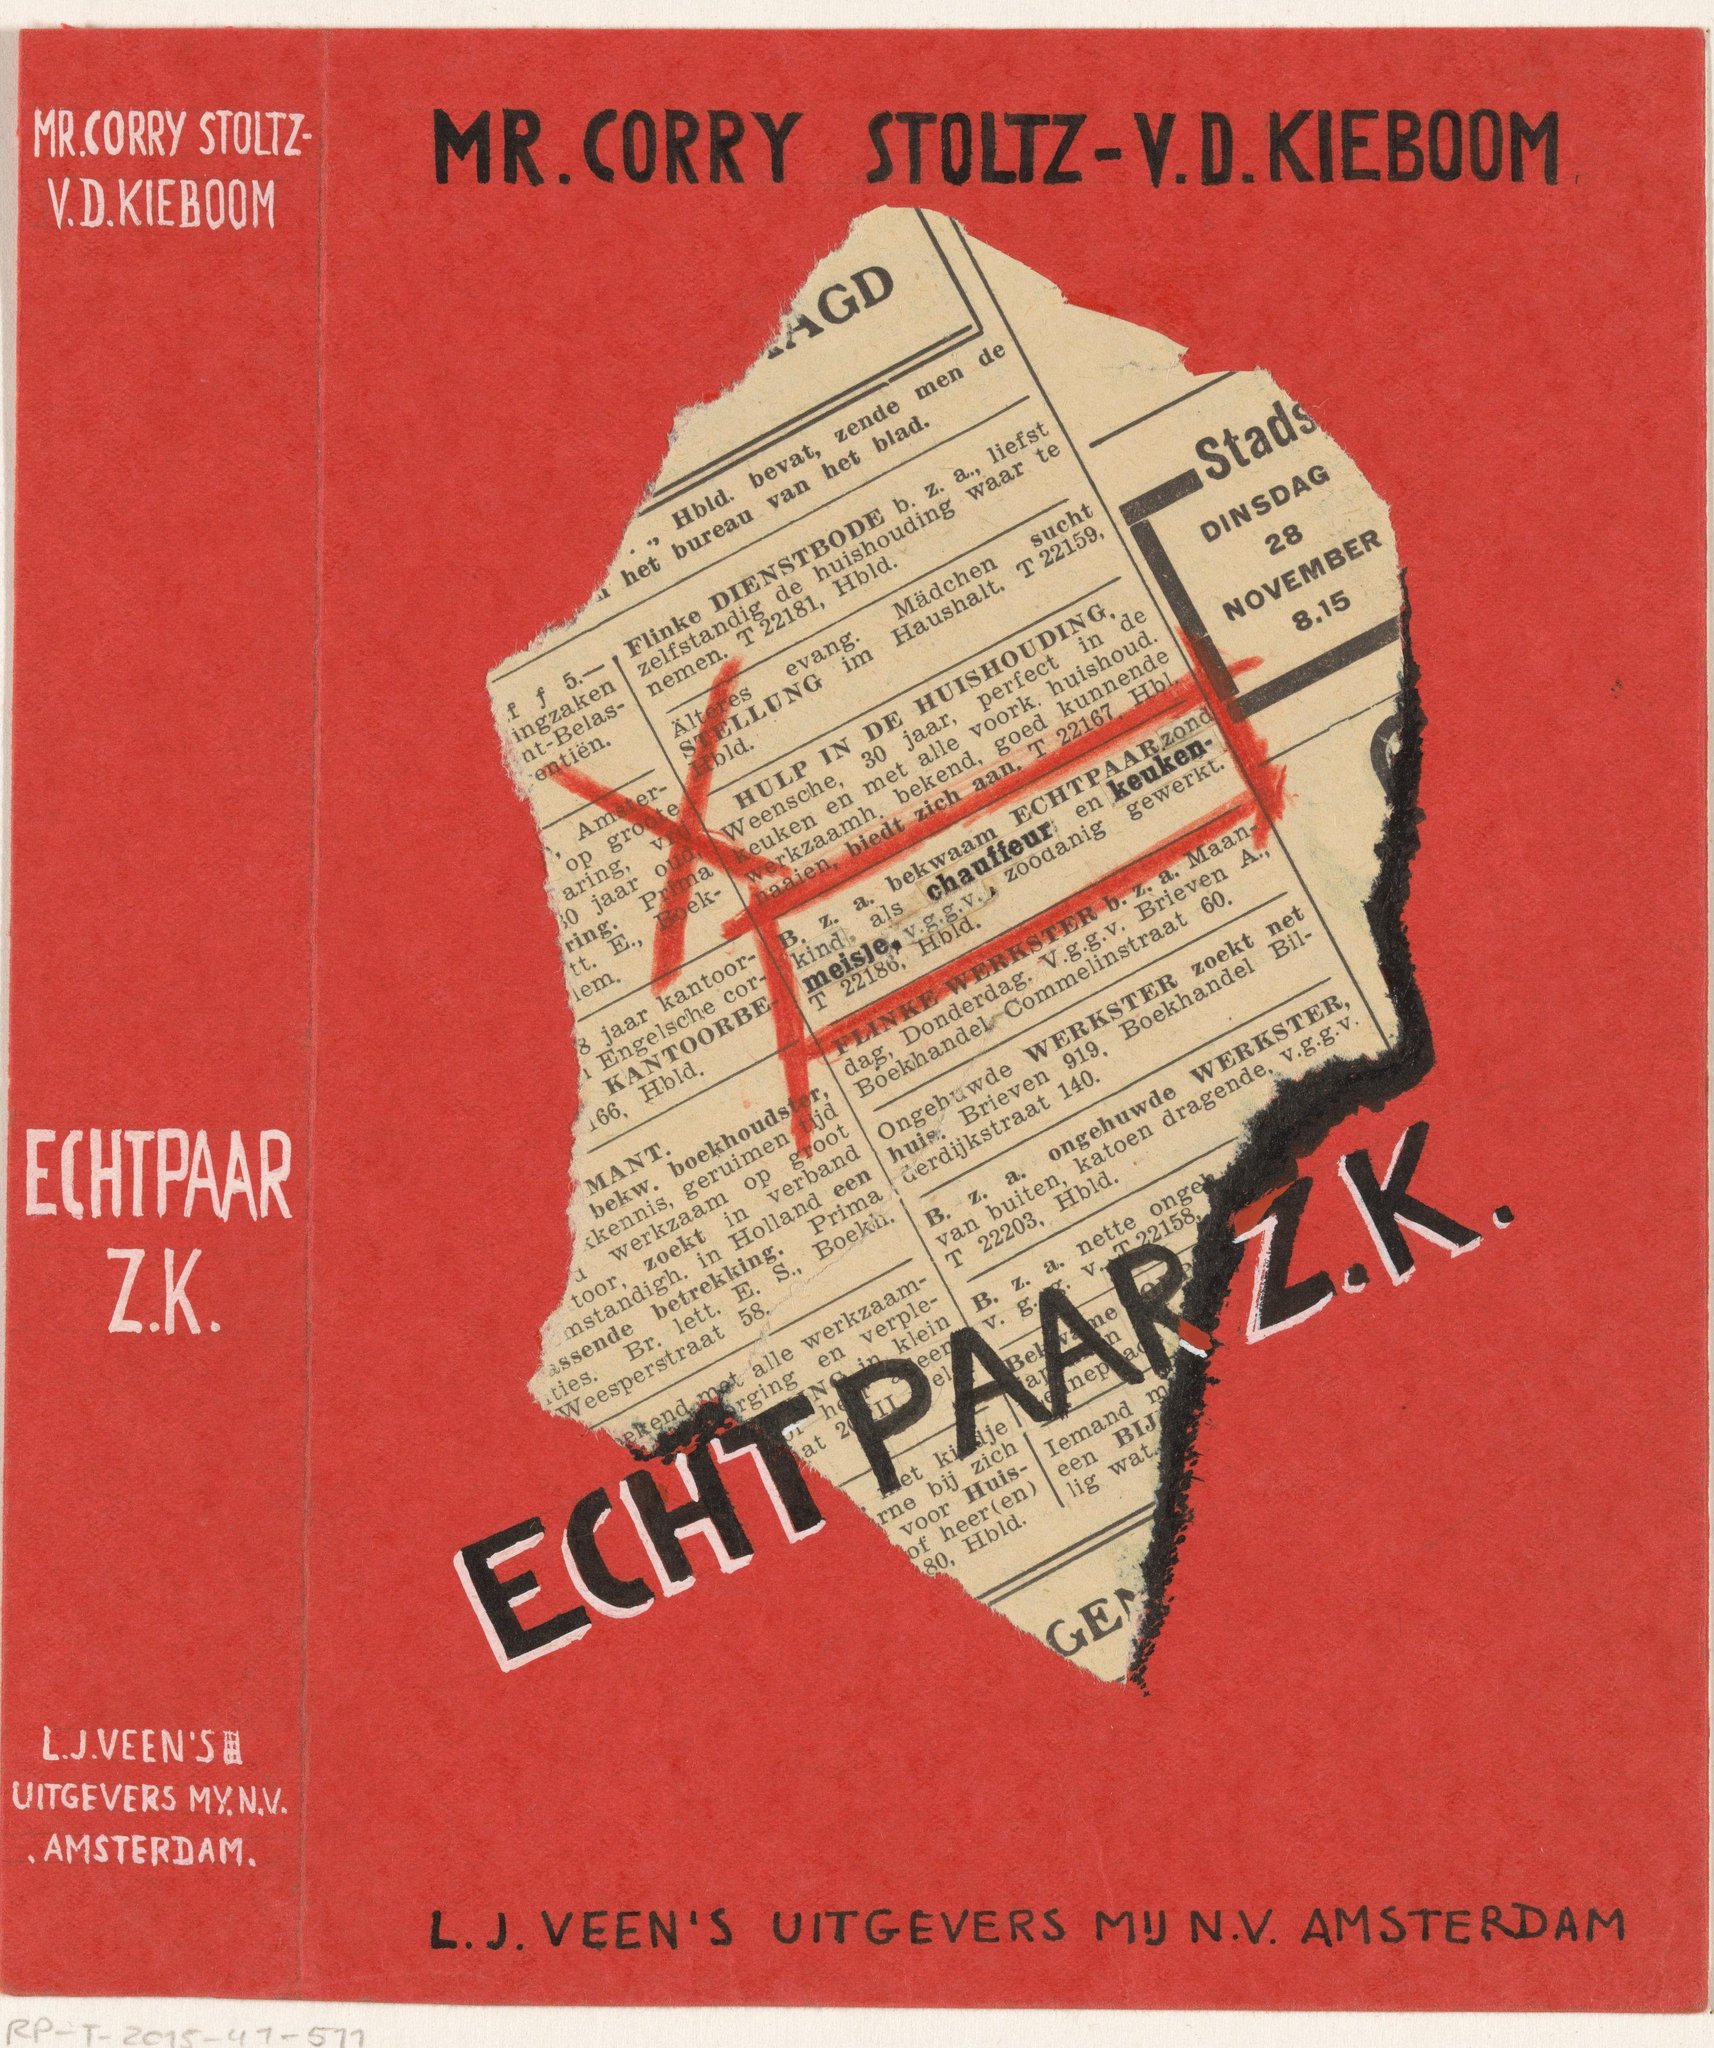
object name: collage visual work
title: Bandontwerp voor: Corry Stoltz-Van den Kieboom, Echtpaar z.k., 1936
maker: g. hagemeyer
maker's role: illustrator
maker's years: -1958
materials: paint, paper, pencil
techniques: brush, printing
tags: advertisement, notice, newspaper, news-sheet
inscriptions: annotation: ‘O[...]. Ada van den Broek’, collector's mark: Lugt 2228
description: Uitgescheurde krantenpagina met een omcirkelde en met een kruis aangeduide advertentie over een echtpaar zonder kind.